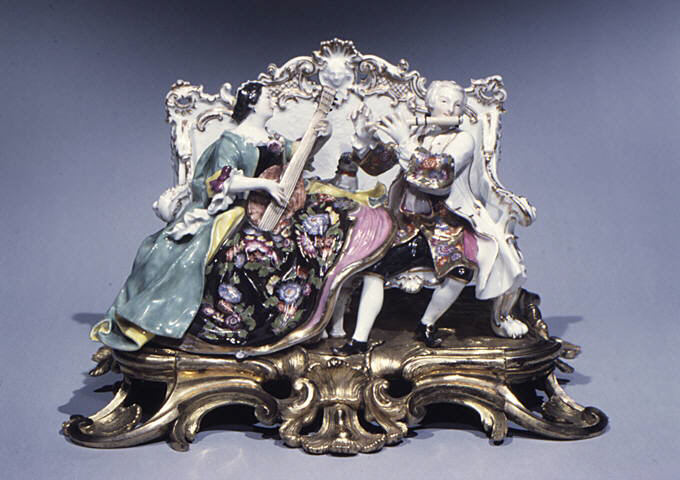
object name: group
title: Couple on a settee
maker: meissen manufactory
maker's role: manufactory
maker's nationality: german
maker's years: 1710-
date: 1737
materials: gilt bronze, hard paste porcelain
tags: musical instruments,couples,men,women